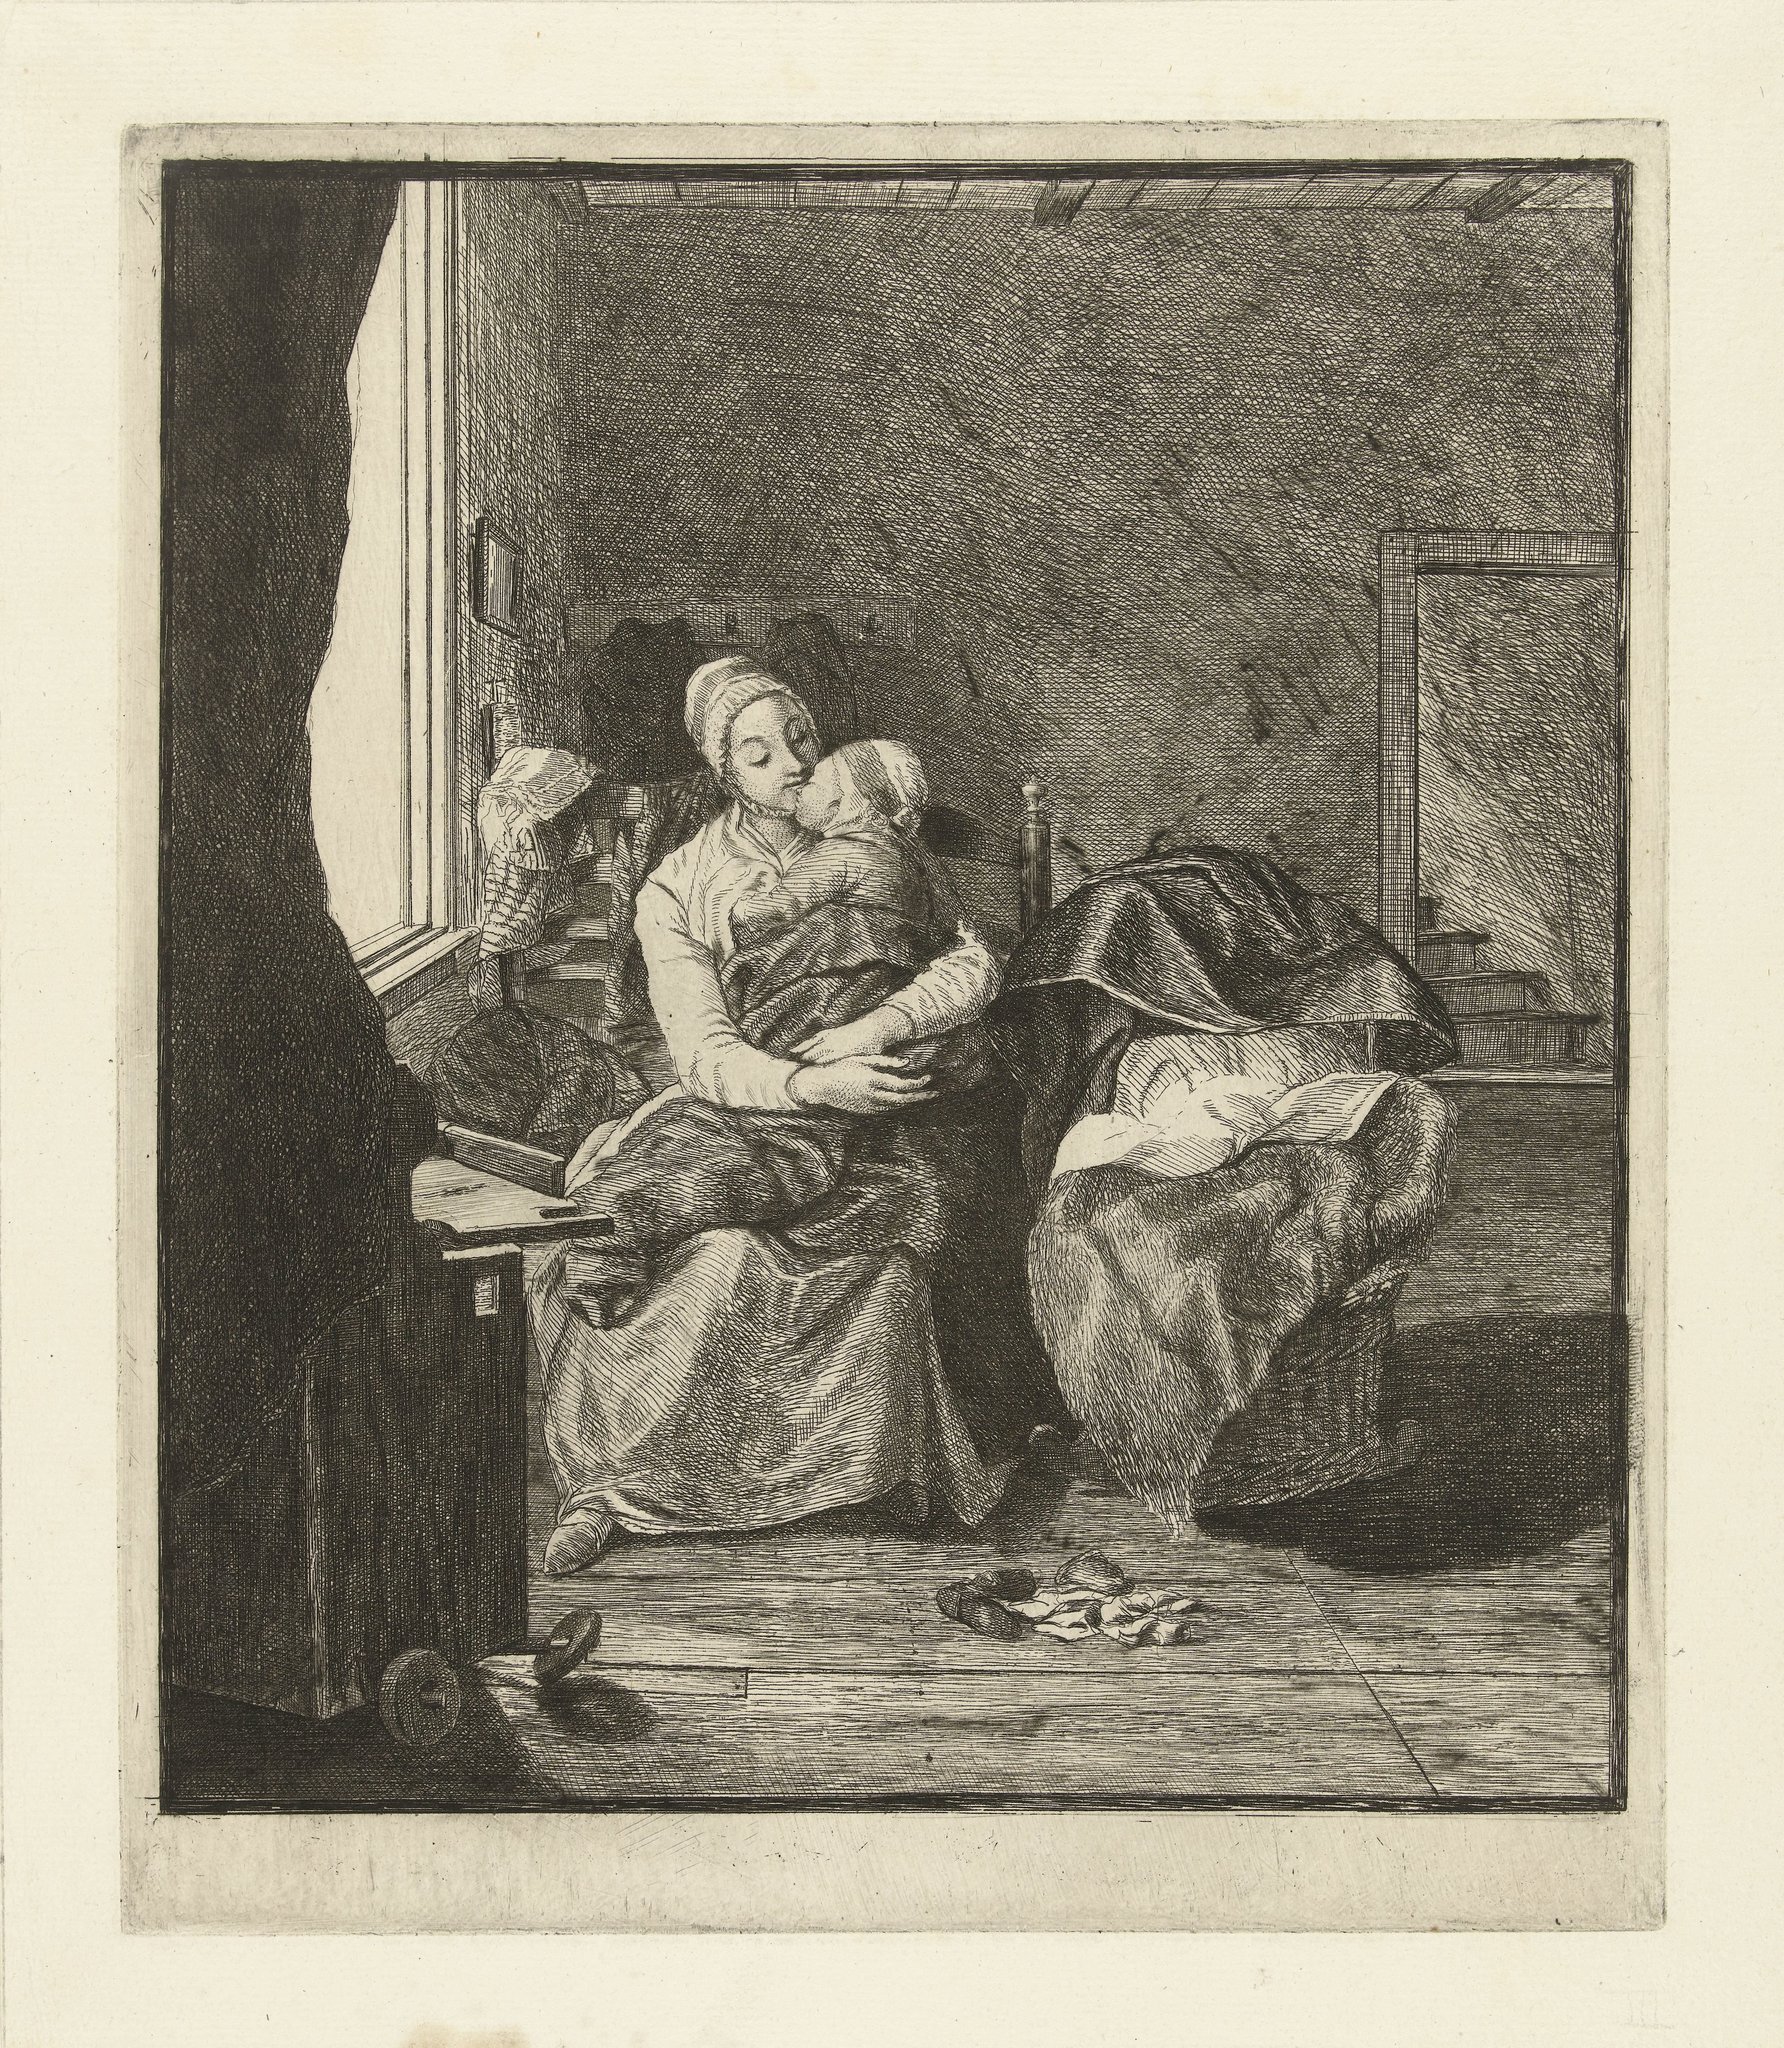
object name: print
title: Moeder met slapend kind voor het raam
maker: louis bernard coclers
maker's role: draughtsman, print maker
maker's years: 1741-1817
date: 1756-1817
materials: paper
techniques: drypoint, etching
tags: baby-chair, head-gear: cap (+ women's clothes), cradle, crib, watching a sleeping child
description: Een jonge moeder zit met haar slapende kind op schoot voor het raam. Naast haar staat de wieg. Links bij het raam een kinderstoeltje op wielen.